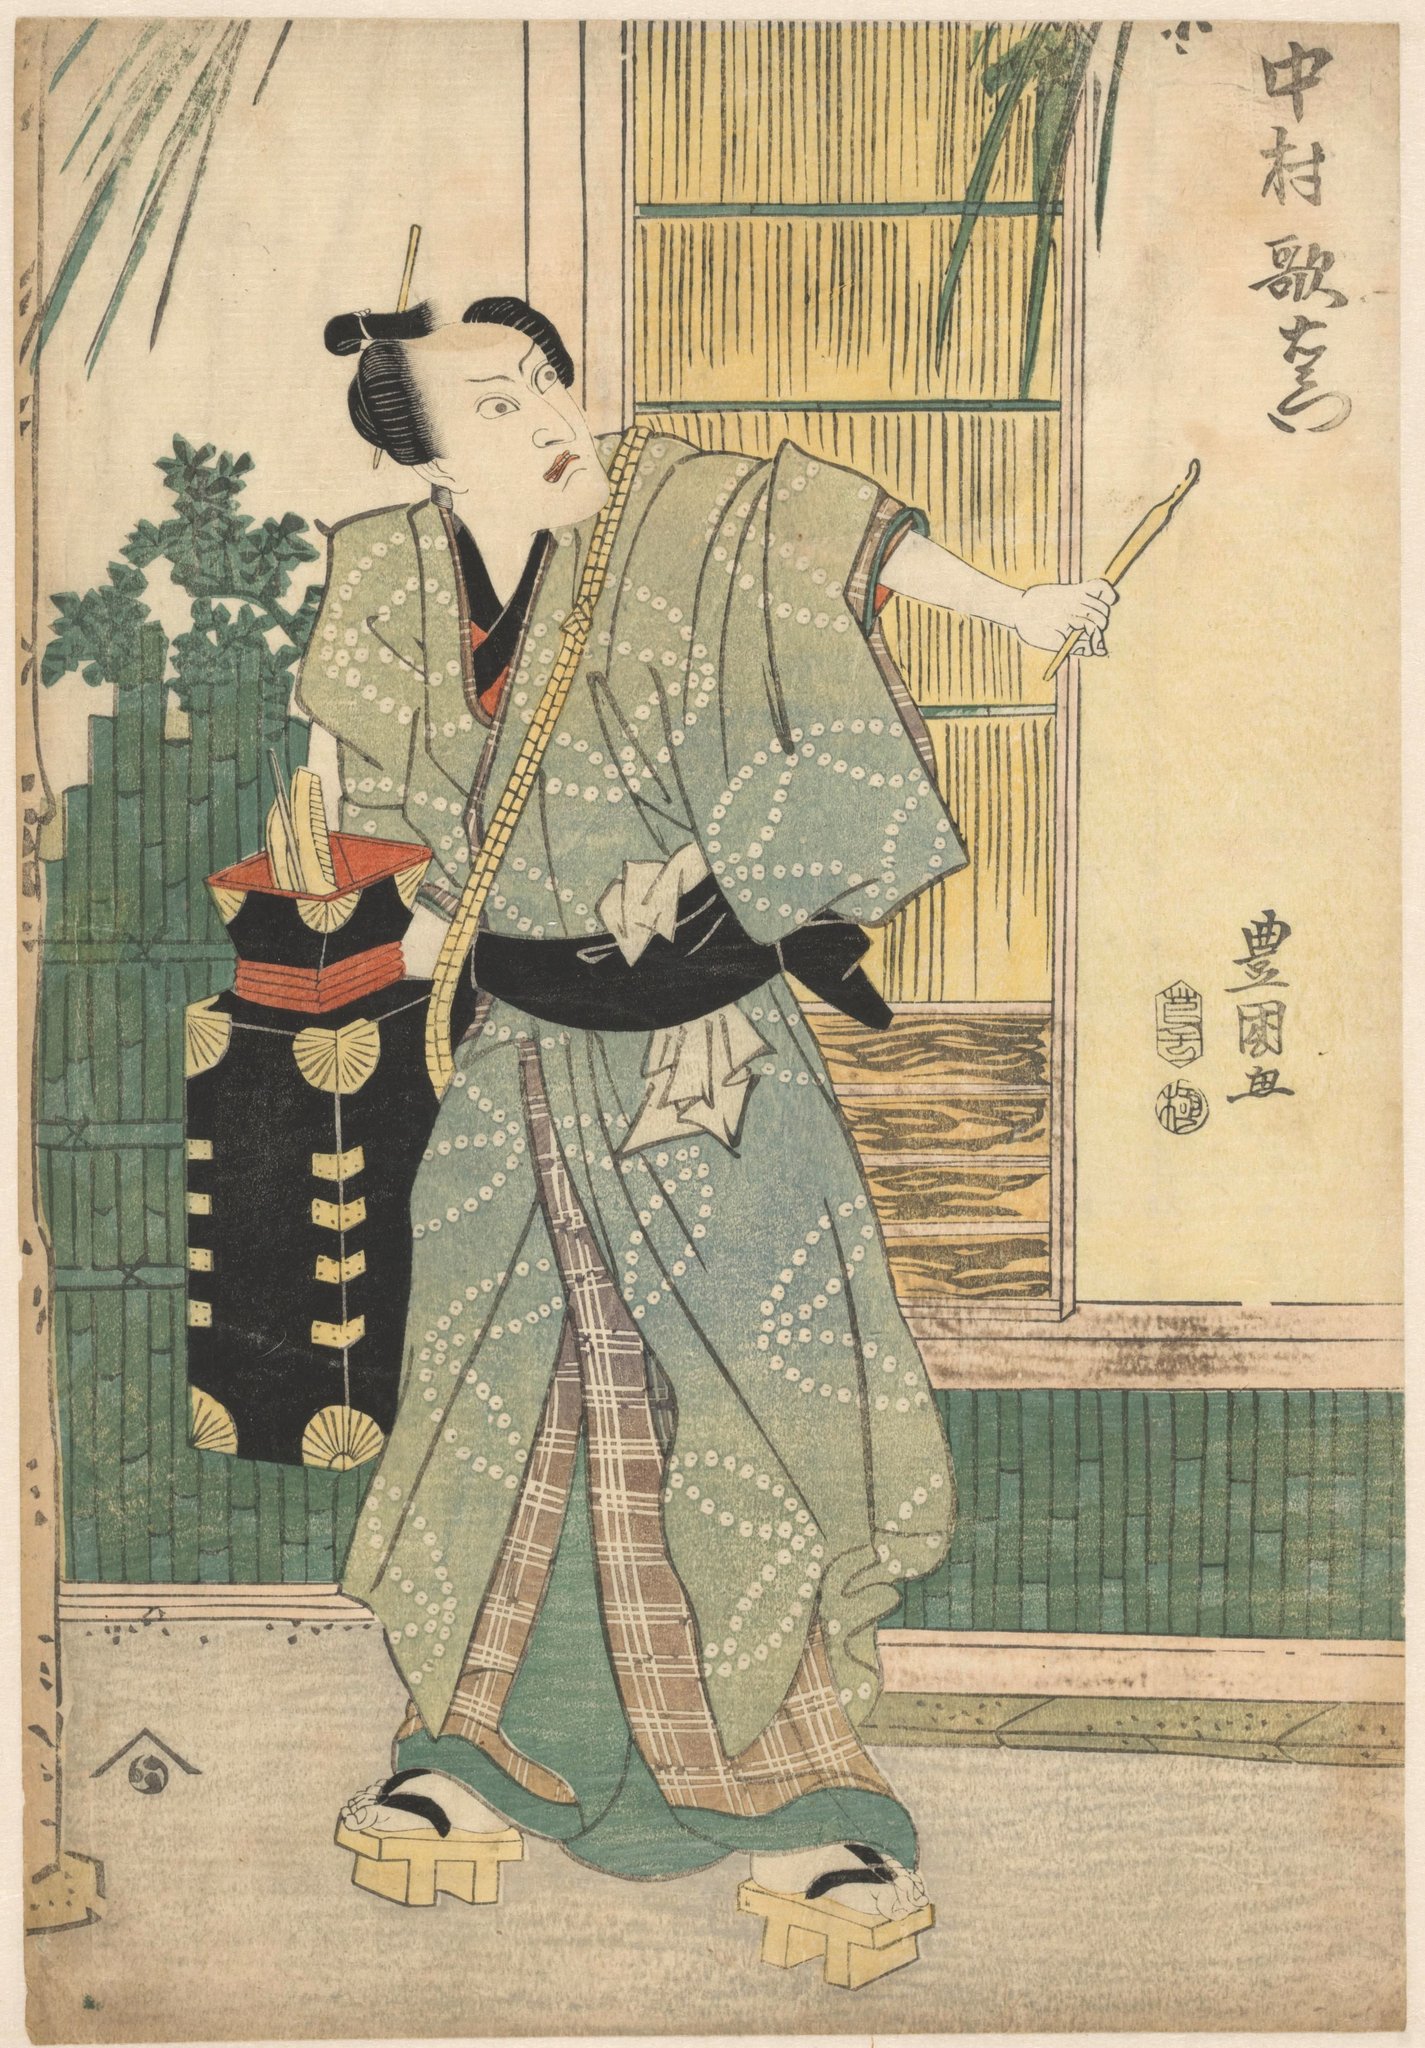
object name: print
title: Hairdresser Gorôhachi carrying a portable case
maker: utagawa toyokuni (i)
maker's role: print maker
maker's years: 1769-1825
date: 1805-1812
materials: paper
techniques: woodcut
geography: japan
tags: carrying something, hairdresser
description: Kabuki acteur Nakamura Utaemon V in de rol van de kapper Gorôhachi met koffer aan zijn schouder en haarpin in de hand. Onderste deel van een verticaal diptiek, waarbij op het bovenste deel serveerster Oritsu vanaf een balkon naar beneden kijkt.